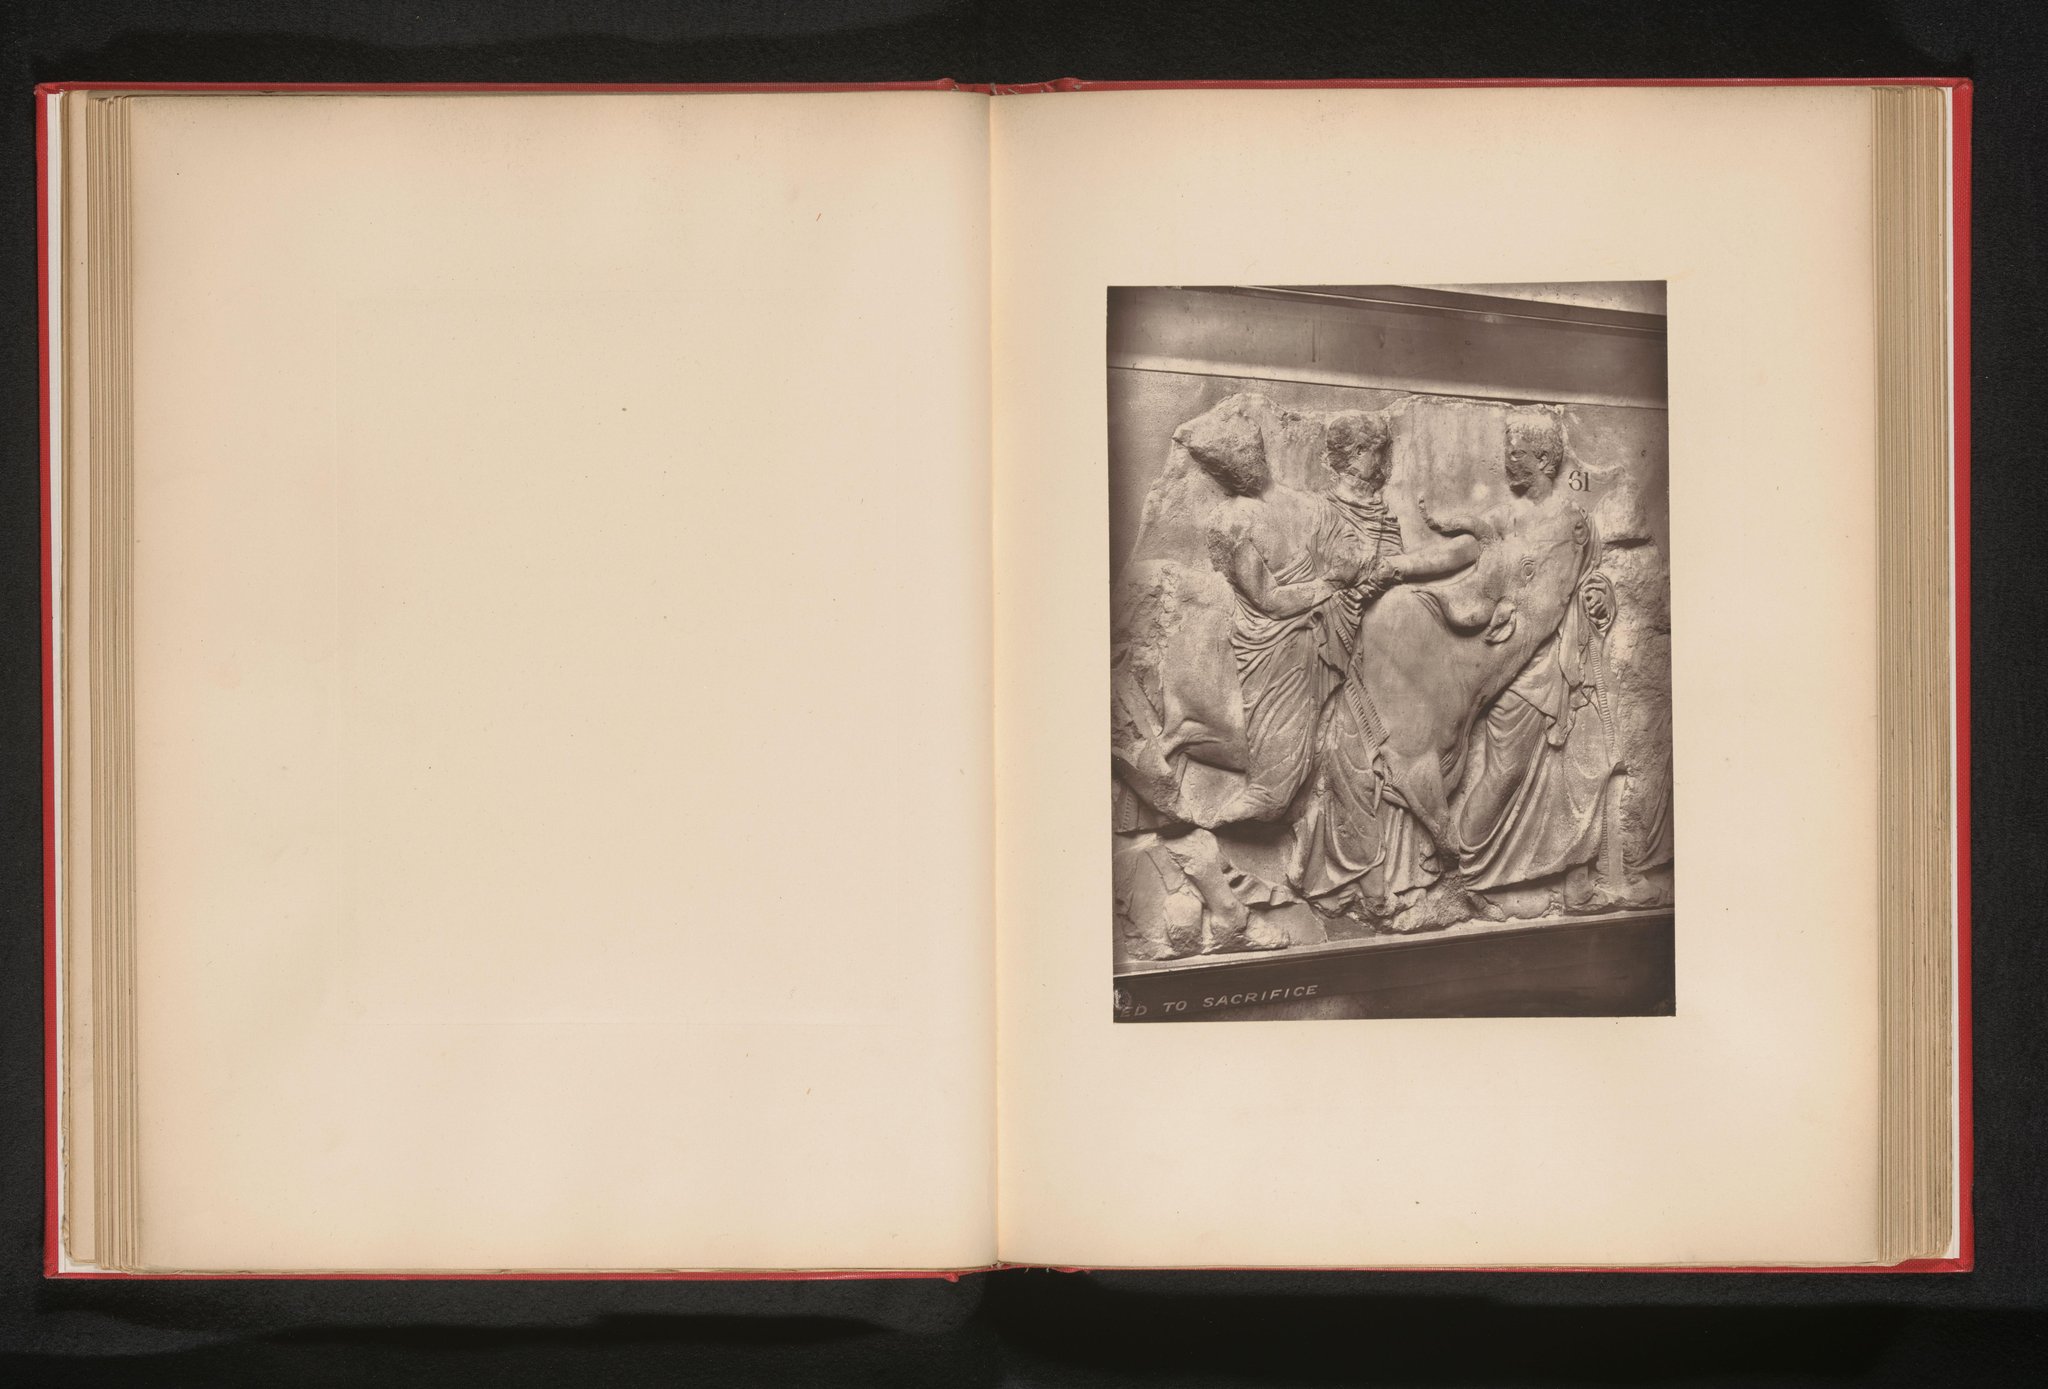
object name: photomechanical print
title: Fries van het Parthenon met priesters die een os offeren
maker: stephen thompson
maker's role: fotograaf, schrijver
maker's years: 1831-1893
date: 1873-1878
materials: paper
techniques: woodburytype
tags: animal sacrifice ~ greek religion, sculpture (+ relief ~ sculpture)